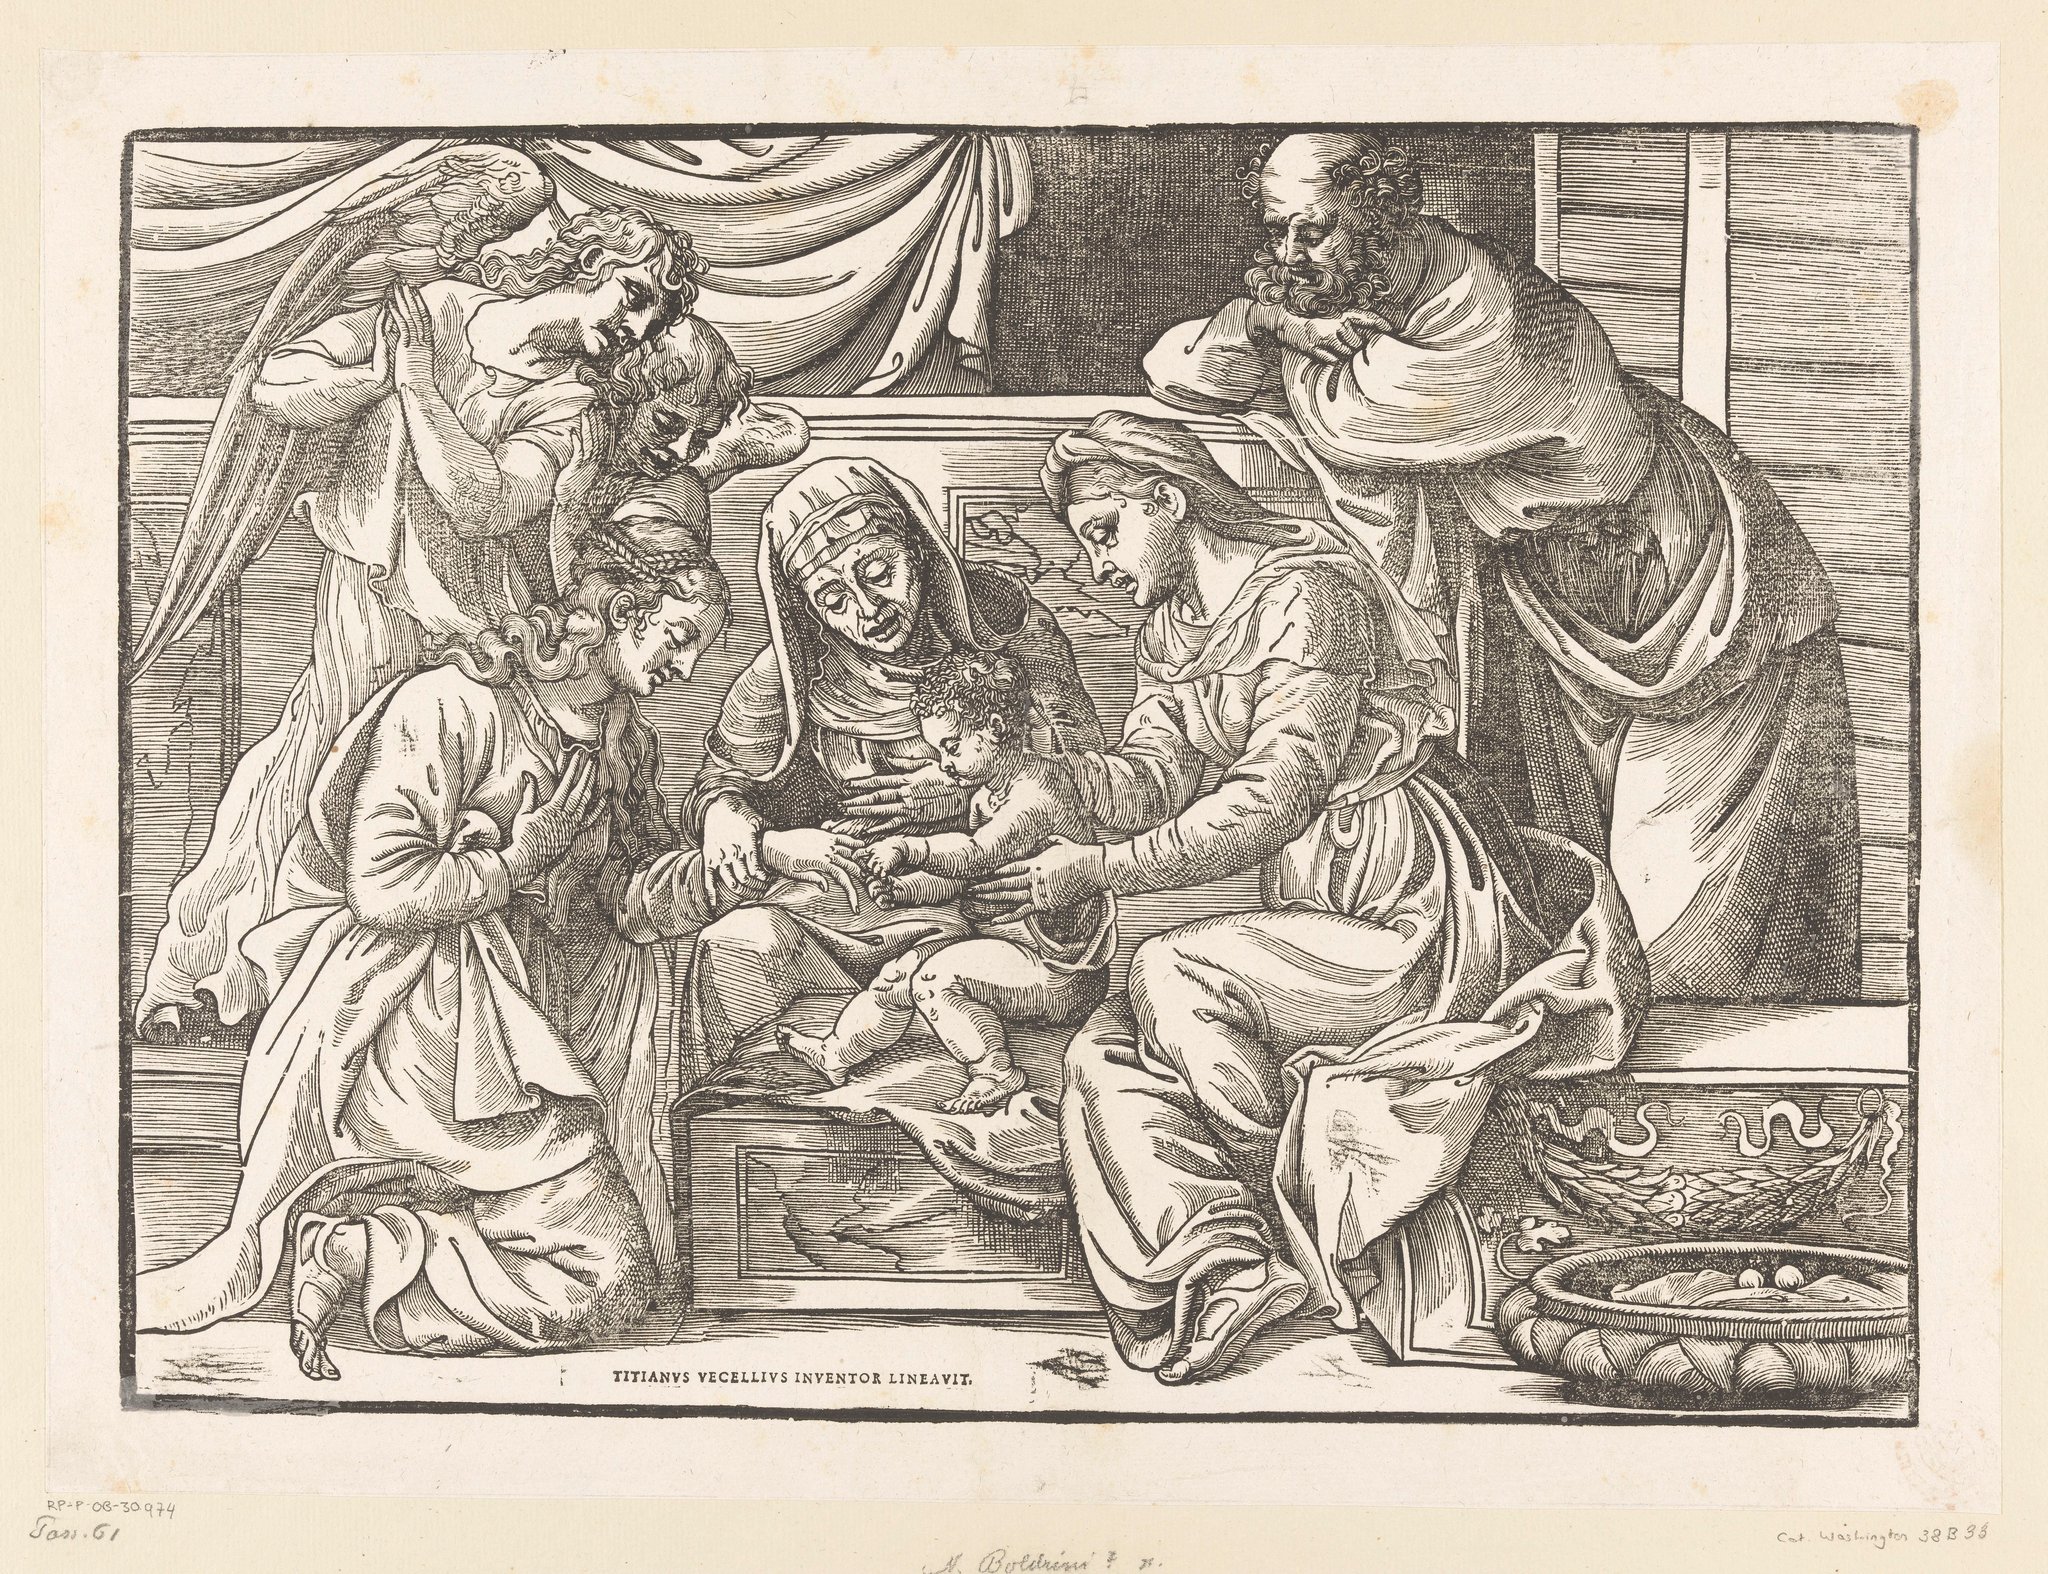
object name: print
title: Mystieke huwelijk van de heilige Catharina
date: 1540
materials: paper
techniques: woodcut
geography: venice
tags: the foster-father of christ, joseph of nazareth, husband of mary; possible attributes: flowering rod or wand, lily, carpenter's tools, the mystic marriage of st. catherine of alexandria with the infant christ: the christ-child puts a ring on her finger, angels in adoration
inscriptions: collector's mark: Lugt 240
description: Maria houdt het Christuskind vast terwijl deze een ring om de vinger schuift van de heilige Catharina die voor hem knielt. Links twee aanbiddende engelen en rechts Jozef. In het midden een oudere vrouw, mogelijk de heilige Anna.